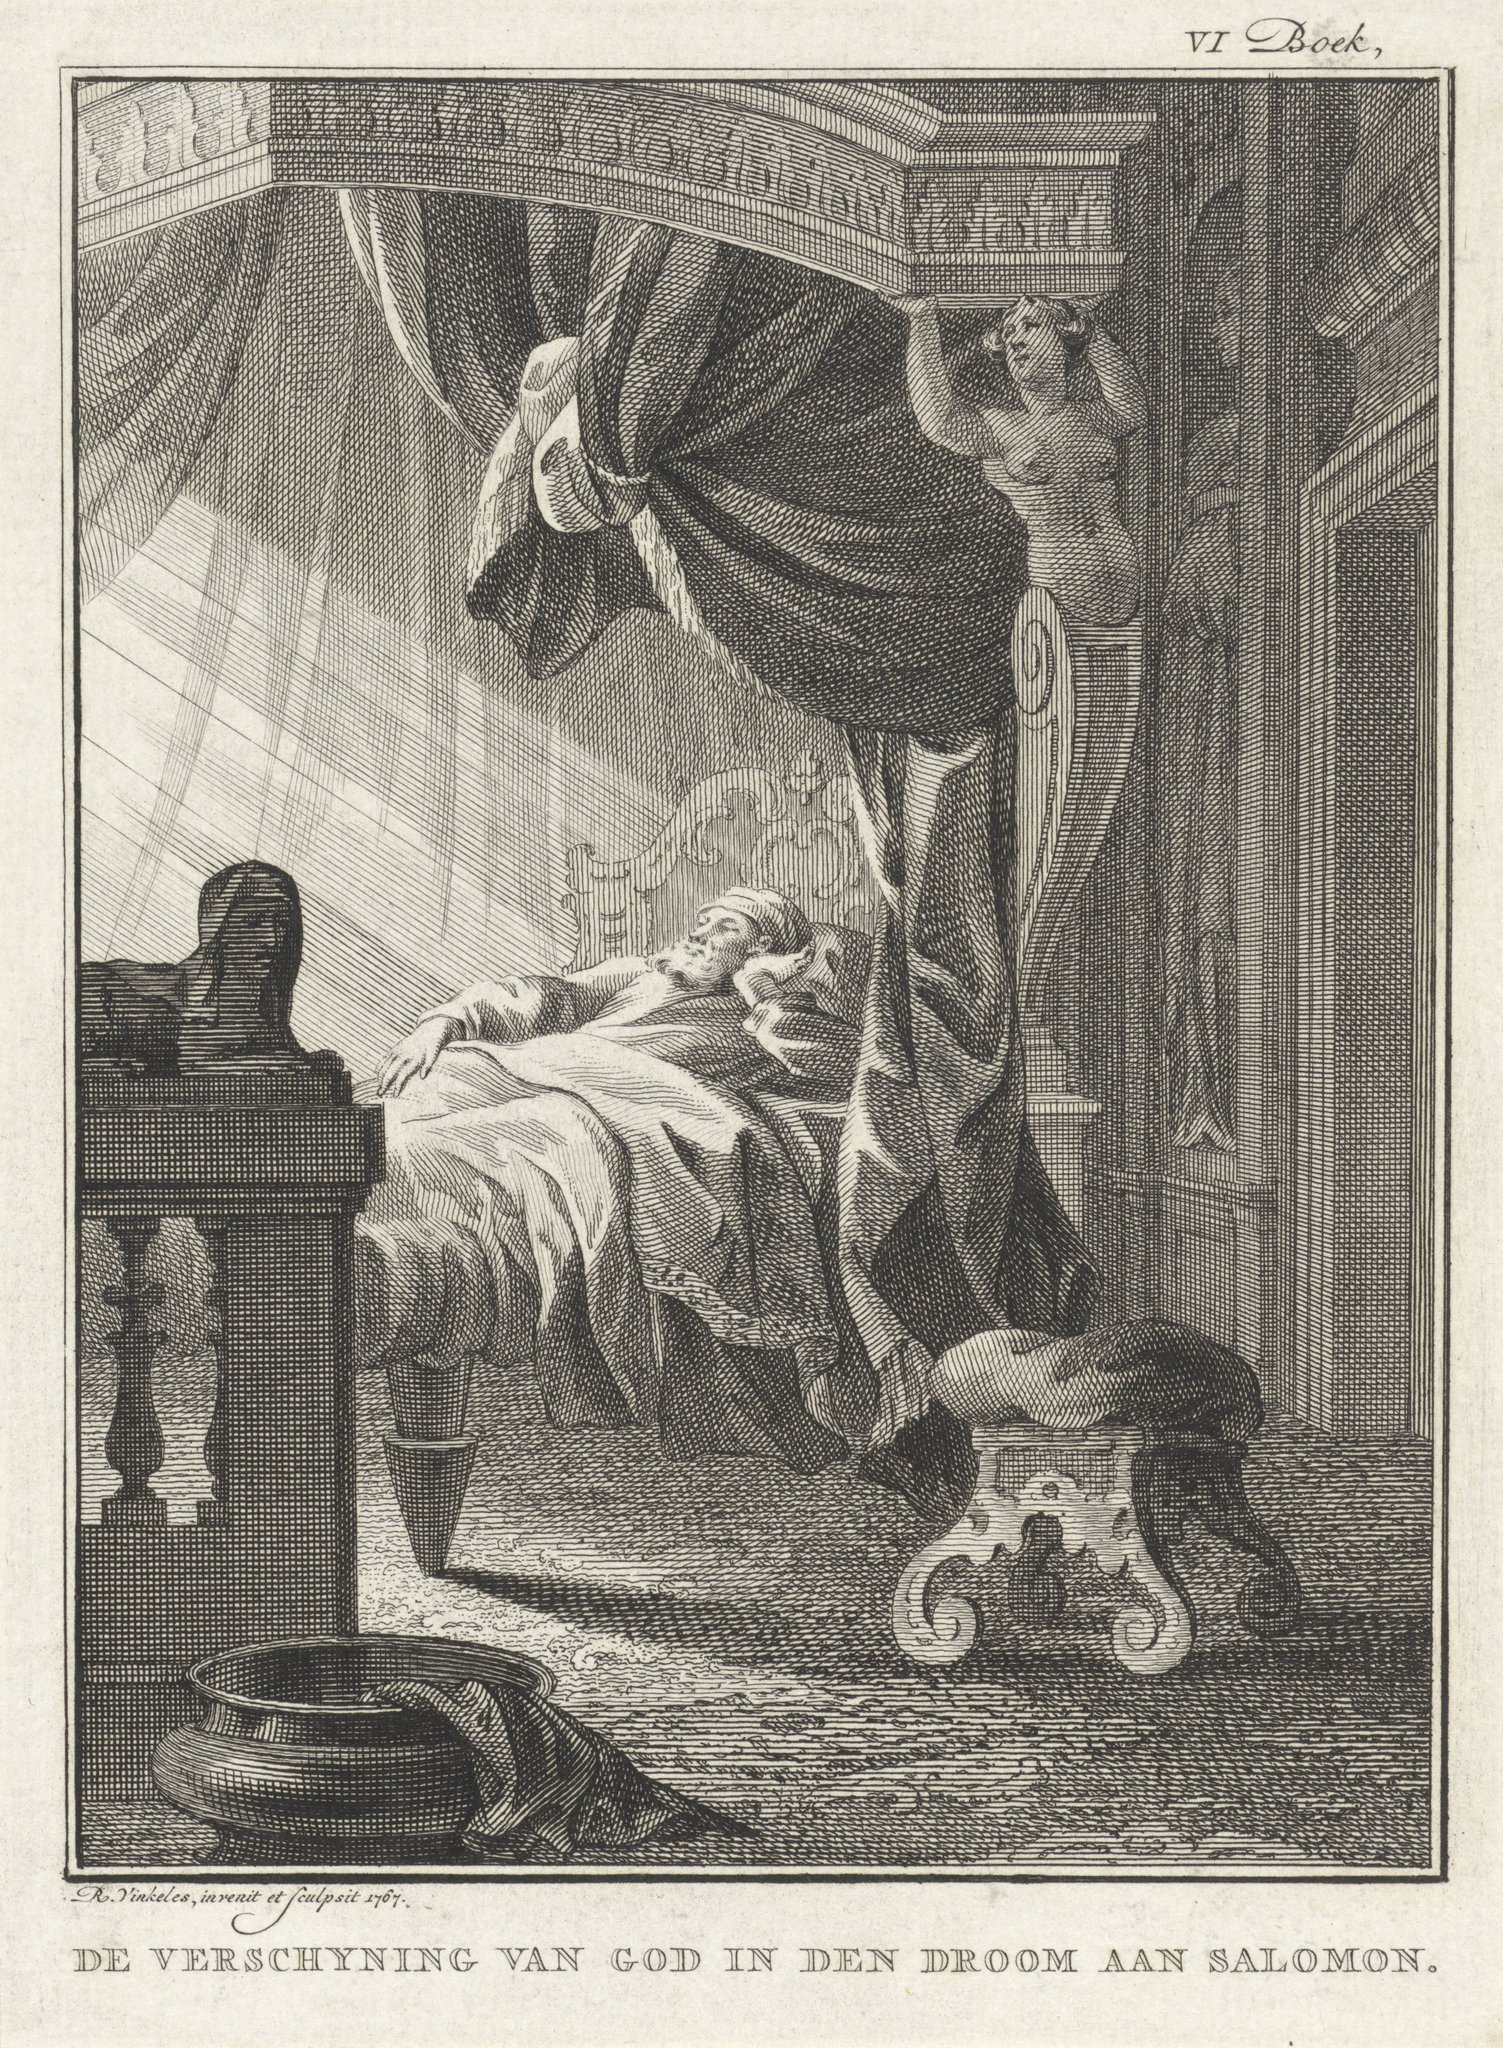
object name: print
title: God verschijnt aan Salomo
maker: reinier vinkeles (i)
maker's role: draughtsman, print maker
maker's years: 1741-1816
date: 1767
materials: paper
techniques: engraving, etching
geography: amsterdam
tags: solomon's dream: the lord appears to him; solomon prays for wisdom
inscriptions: collector's mark: Lugt 240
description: Koning Salomo droeg in Gibeon, de belangrijkste offerhoogte van het land, duizend dieren op het altaar als brandoffer op. Die nacht verschijnt God aan hem in een droom. Daarin vraagt hij God om wijsheid.